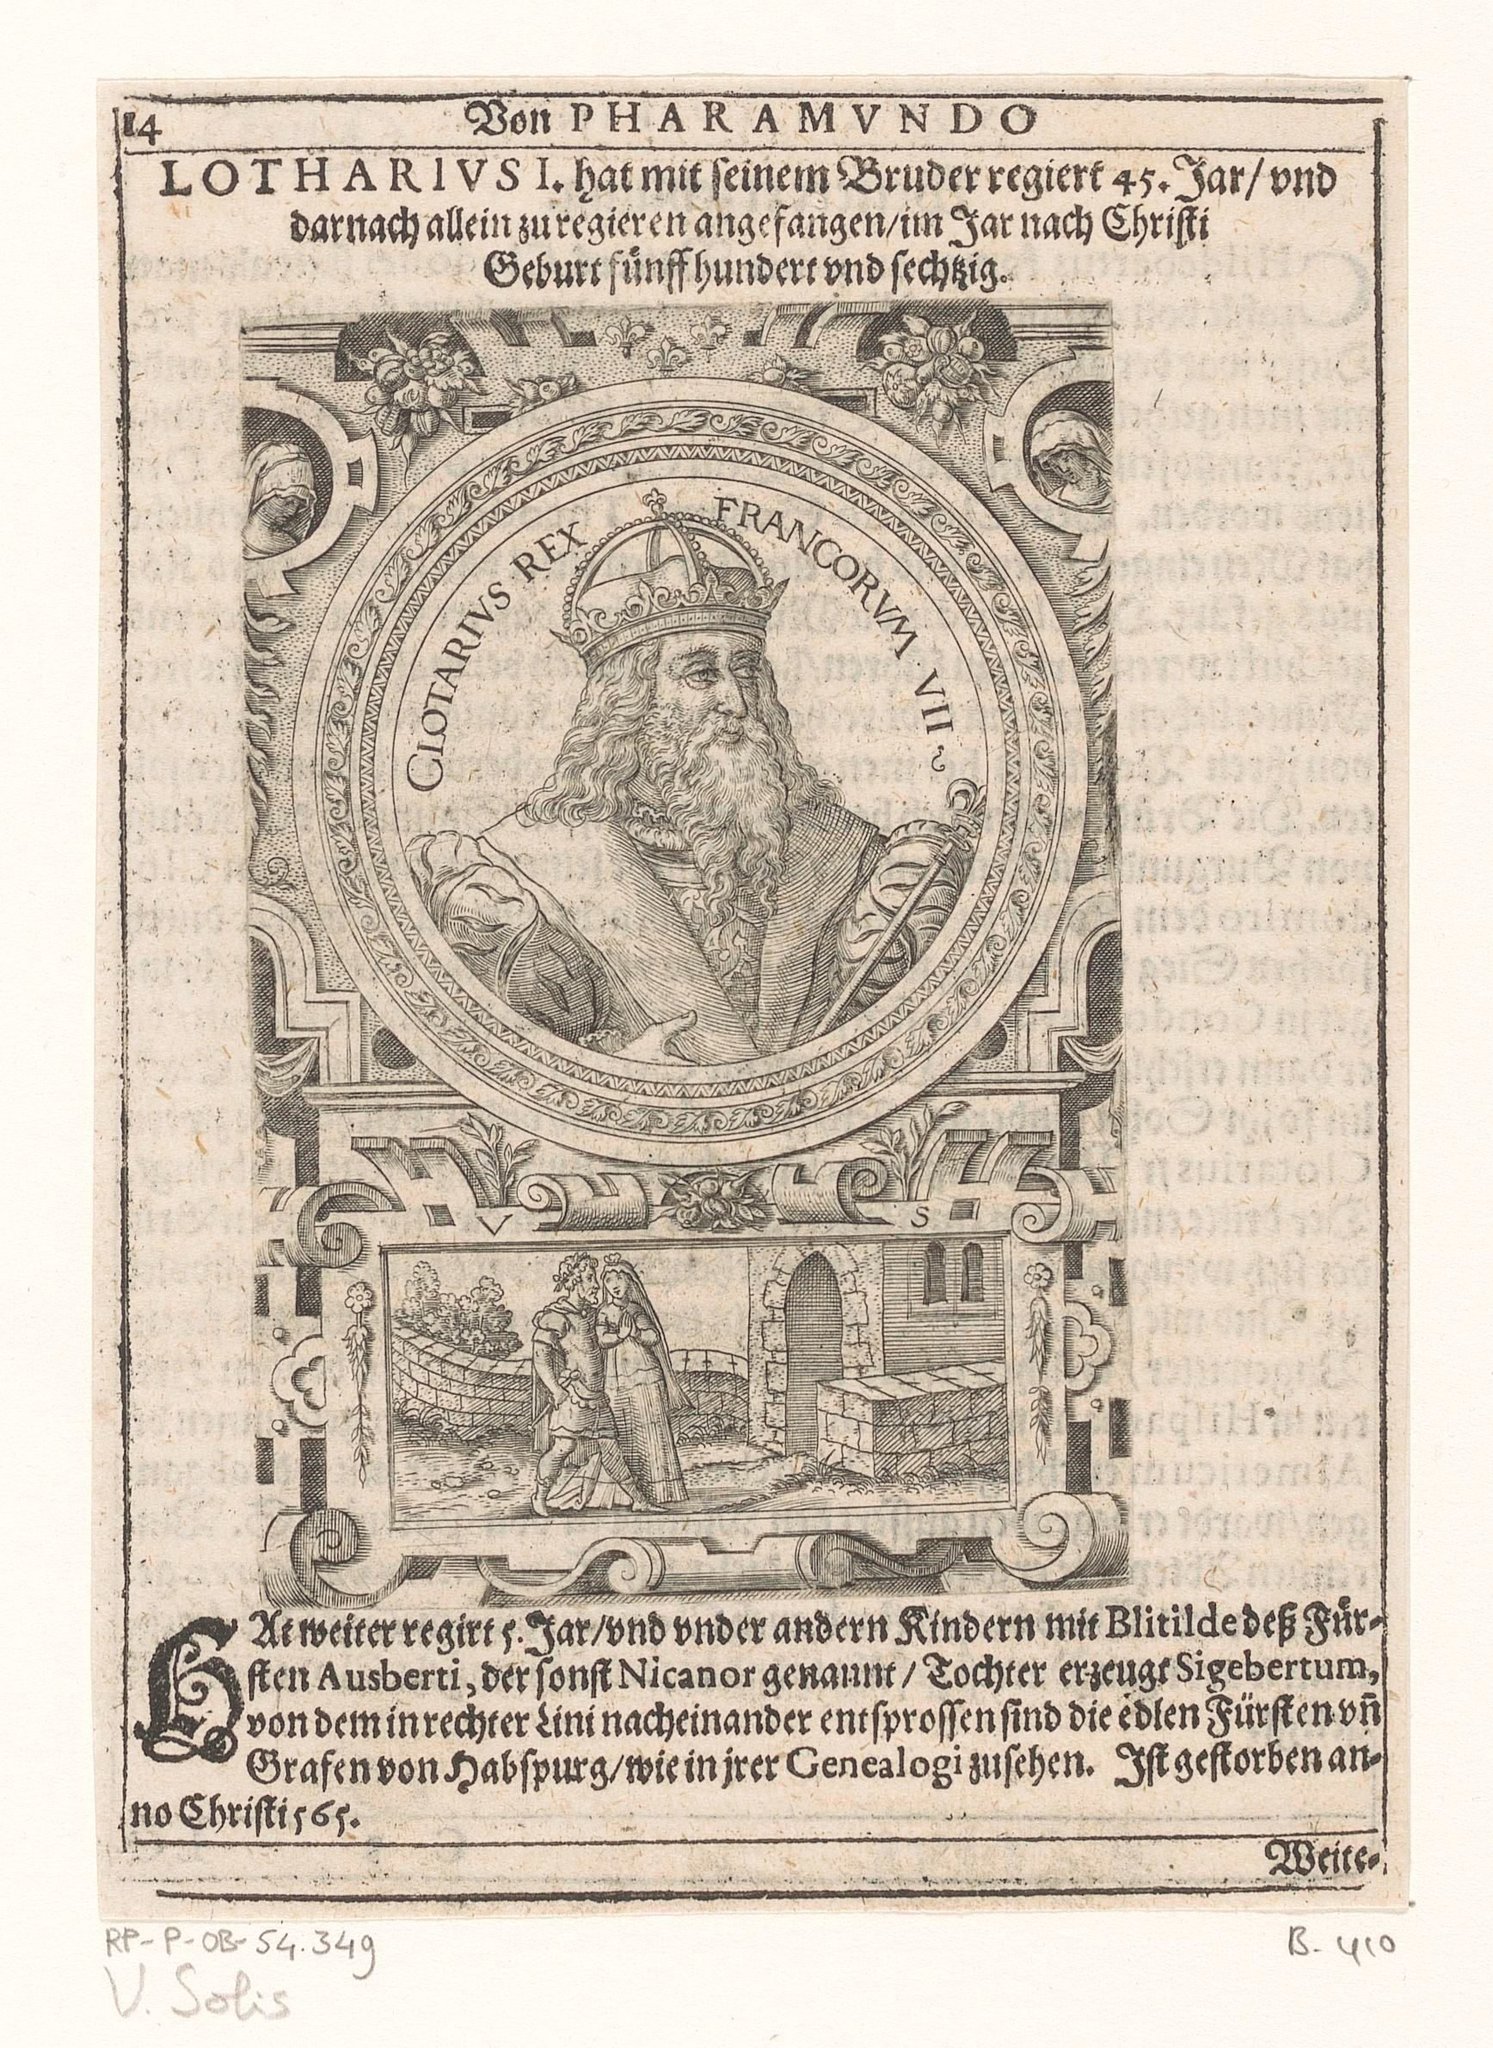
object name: book illustration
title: Portret van Chlotharius I, koning der Franken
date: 1598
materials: paper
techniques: engraving, etching, intaglio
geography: nuremberg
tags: scrollwork, strapwork ~ ornament, historical persons, ruler, sovereign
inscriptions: number: ‘158’, collector's mark: Lugt 2228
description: Prent afkomstig uit de publicatie: Michael Eizinger. Könige in Frankreich. Keulen: Johann Bussemacher, 1598, p. 14. De publicatie bevat prenten van Jost Amman en Virgil Solis.